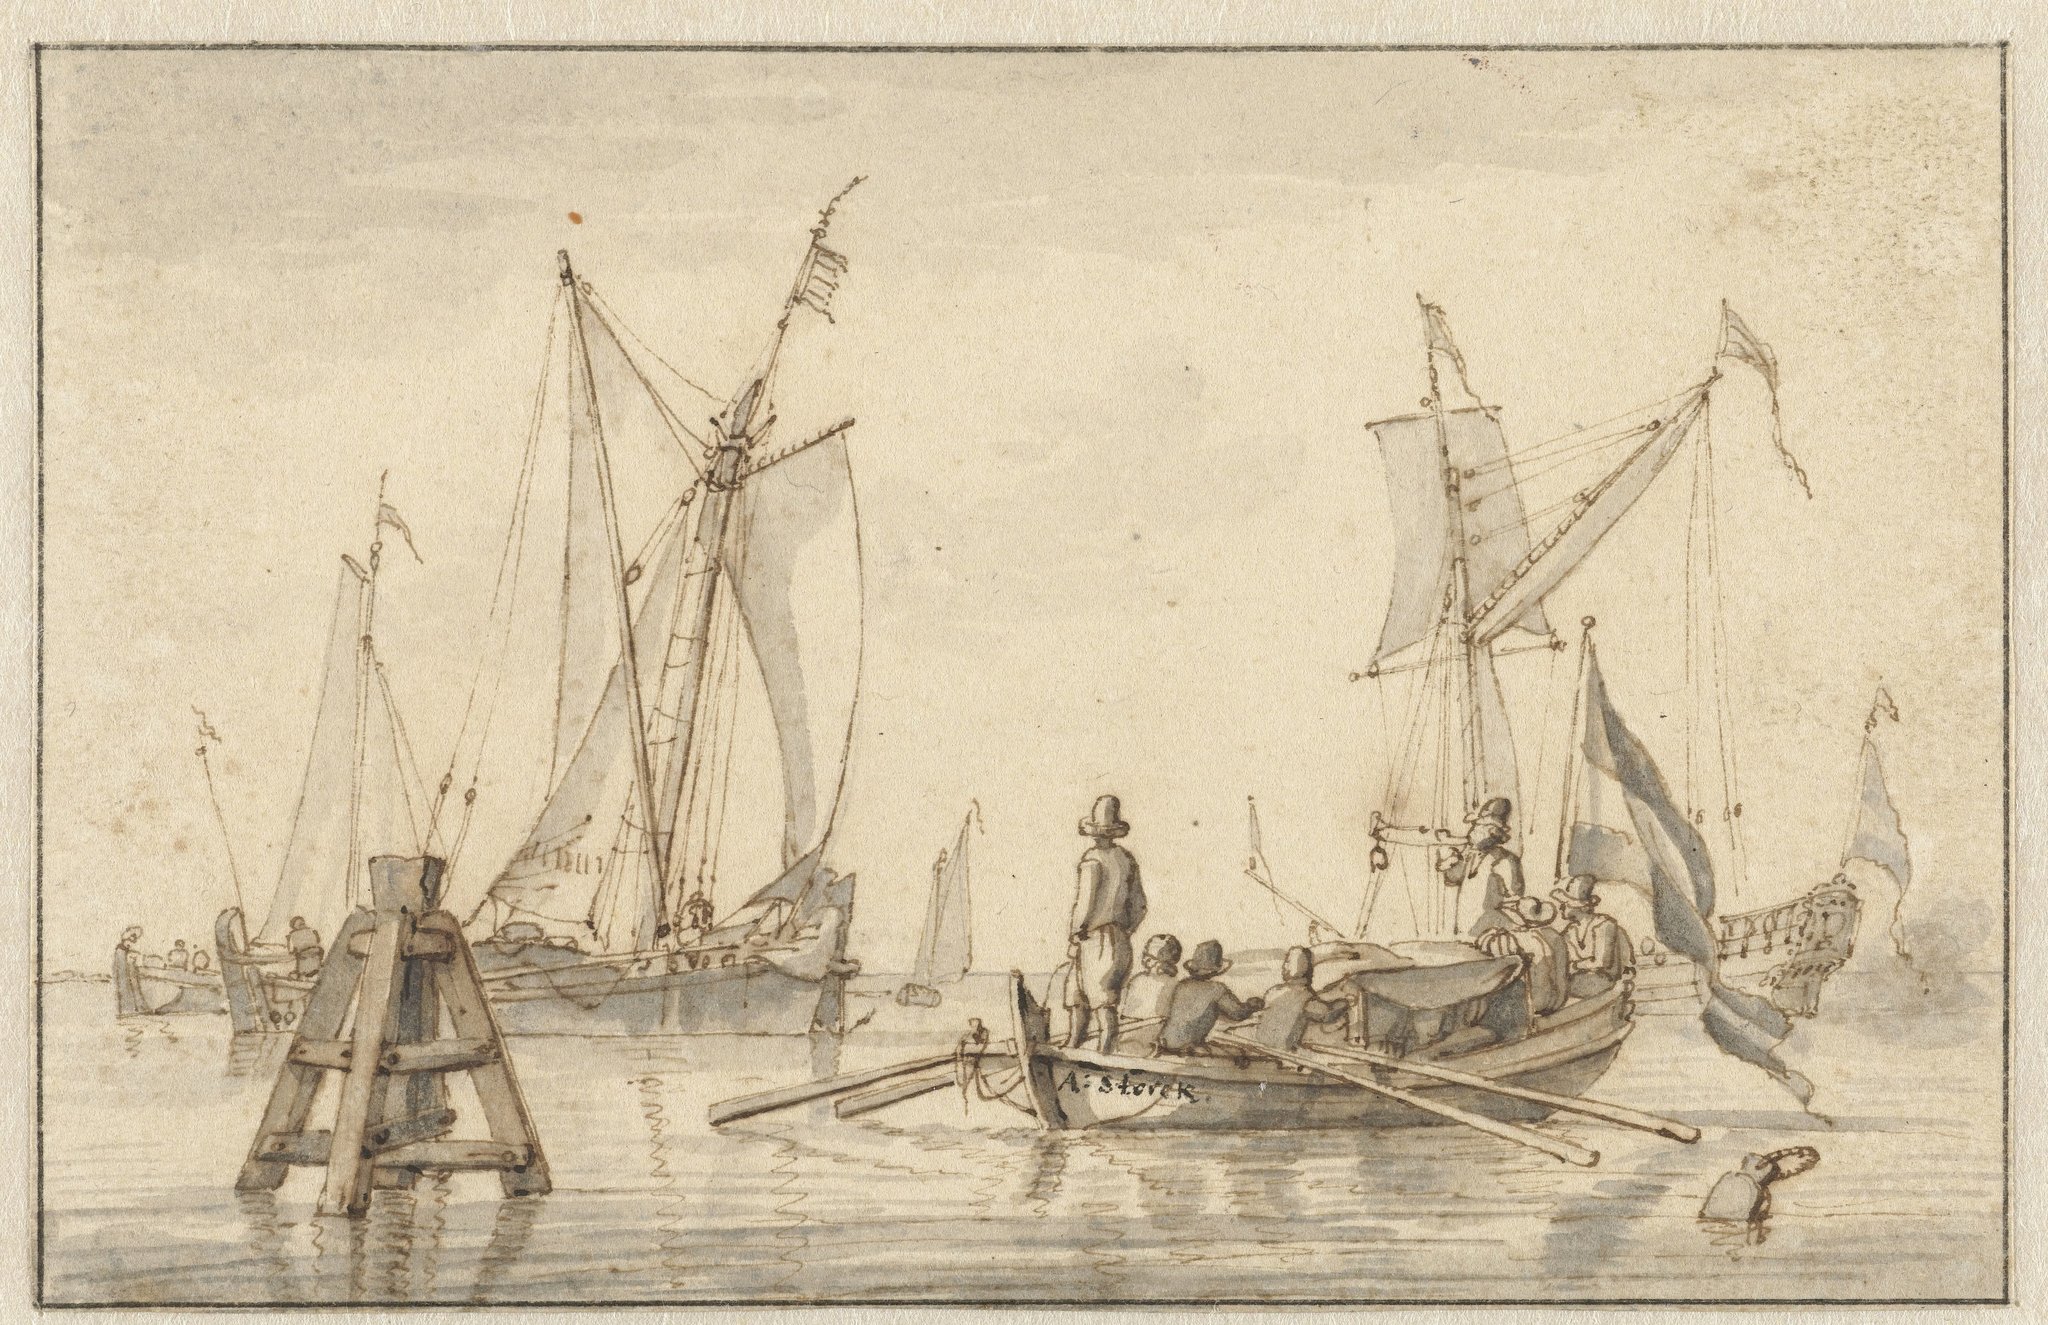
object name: drawing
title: Stille zee met enkele boten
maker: abraham storck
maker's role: draughtsman, painter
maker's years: 1644-1708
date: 1645-1710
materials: ink, paper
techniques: brush, pen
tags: sailing-ship, sailing-boat, rowing-boat, canoe, etc., sea (seascape)